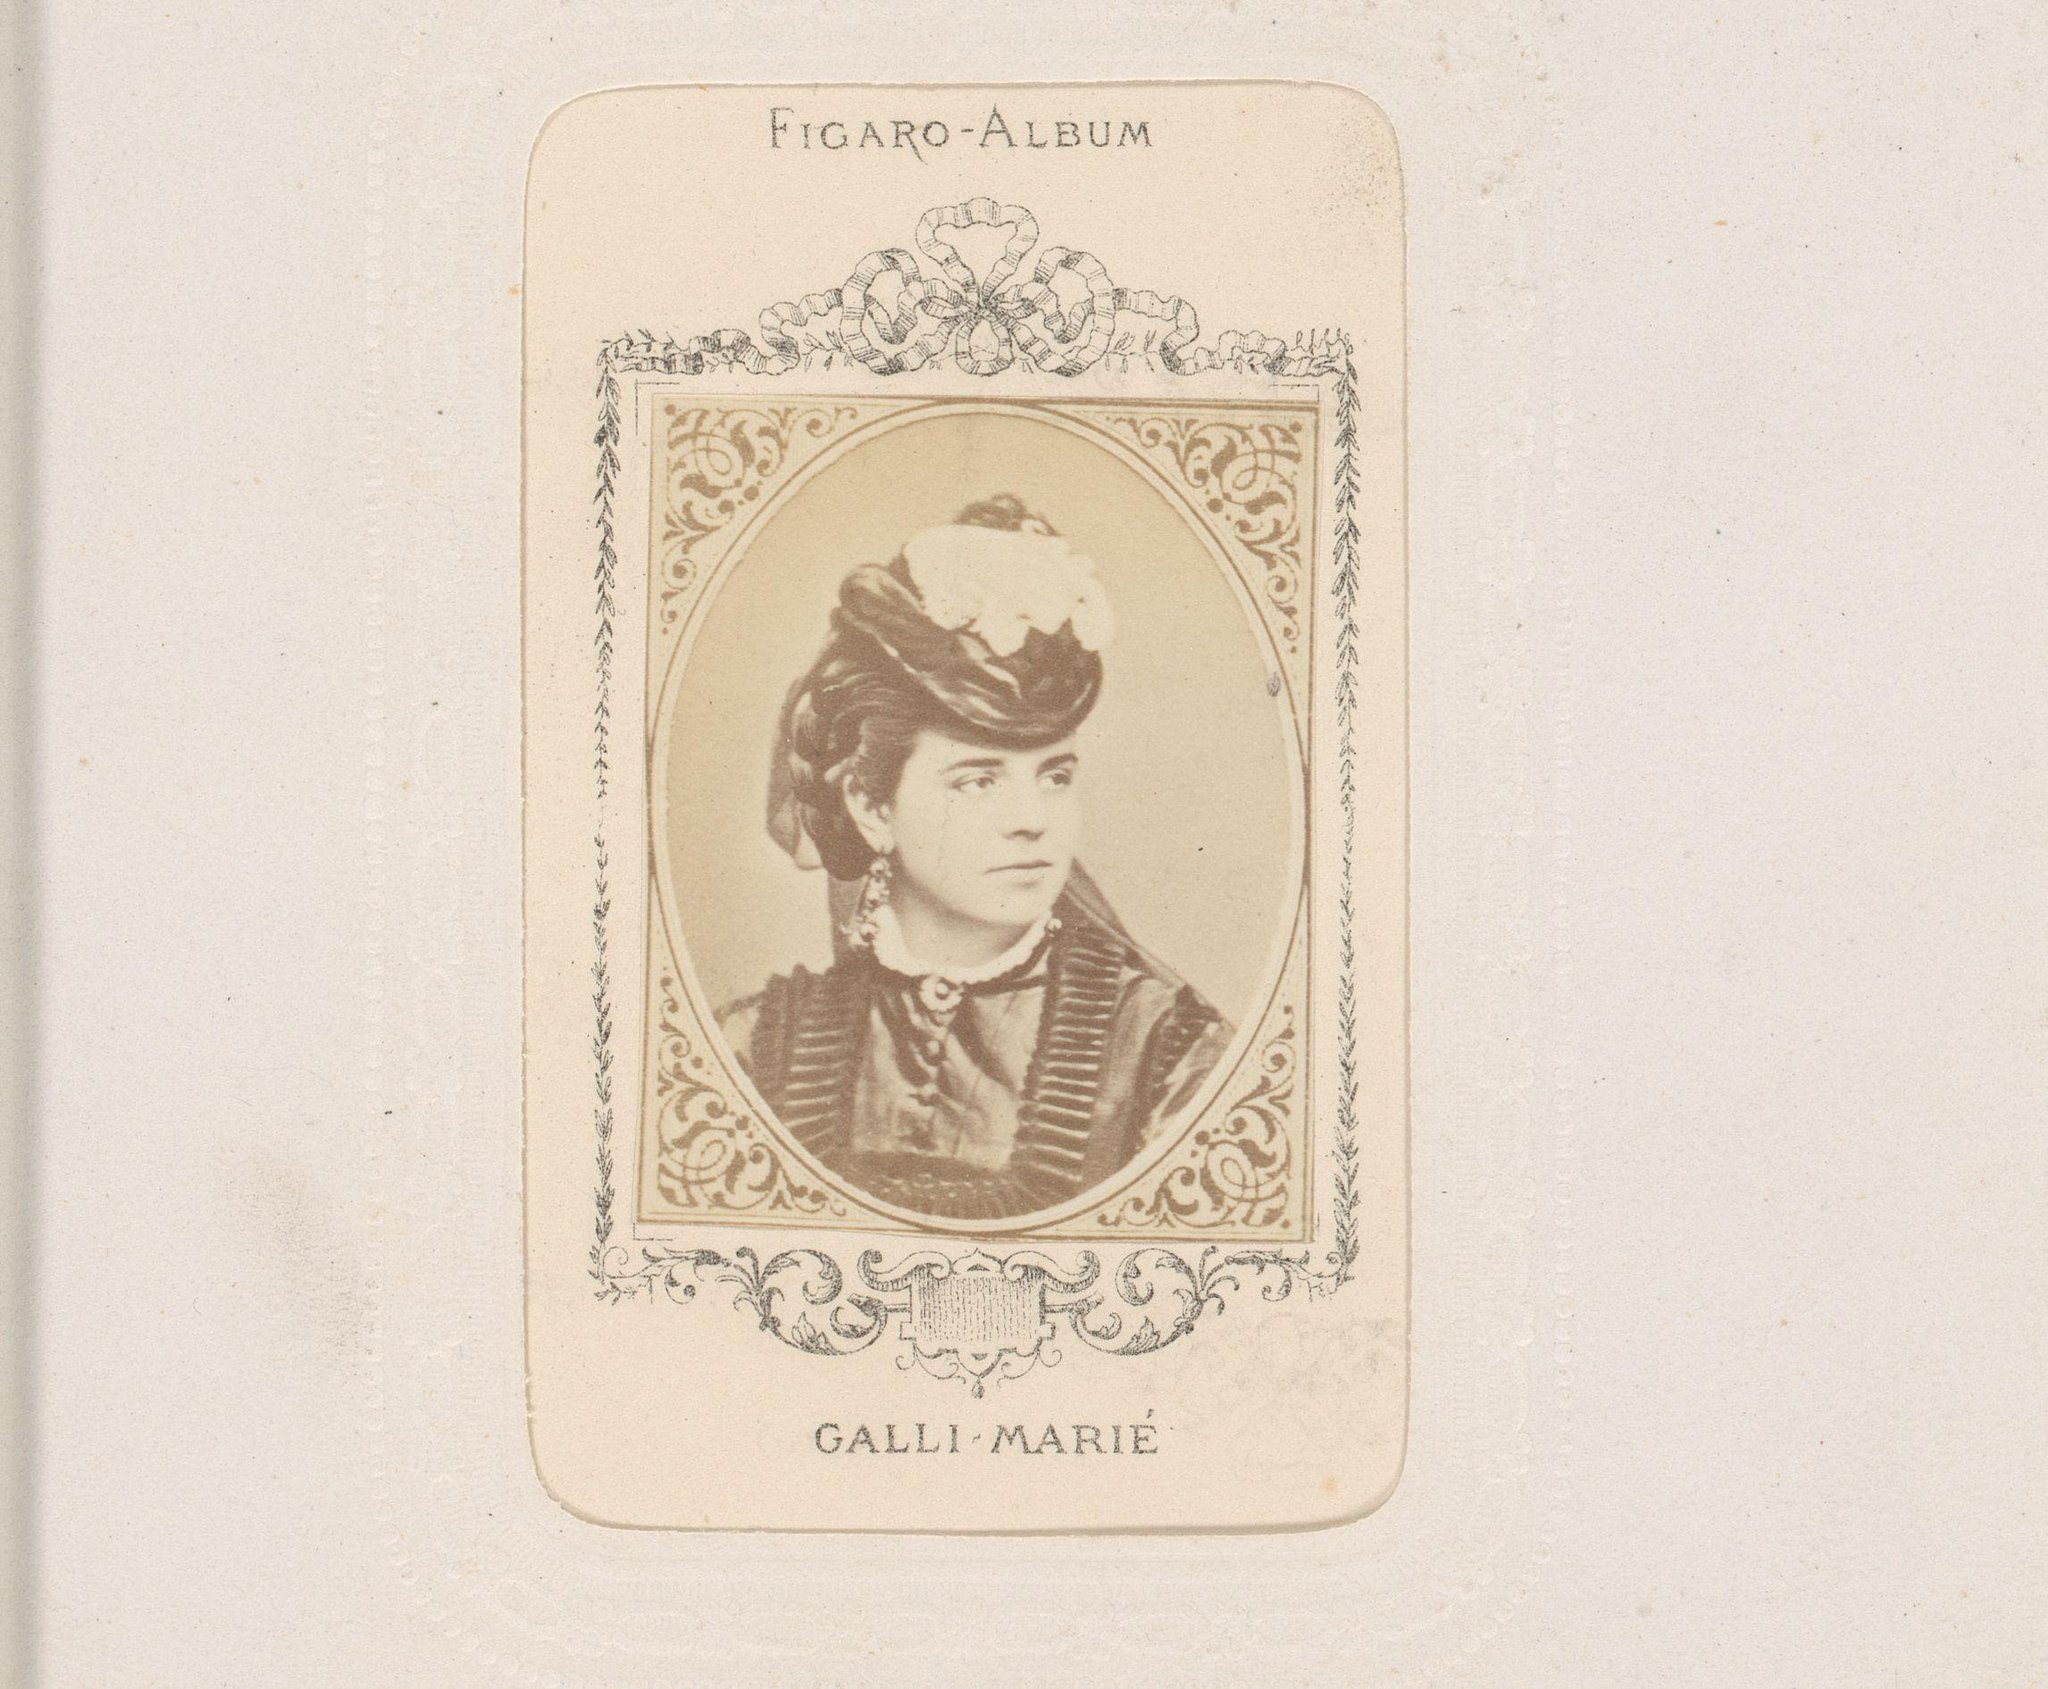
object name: carte de visite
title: Fotoreproductie van een portret van Célestine Galli-Marié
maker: Anonymous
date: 1860-1900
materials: cardboard, photographic support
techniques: albumen print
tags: historical persons - bb - woman, opera-singer (female)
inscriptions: inscription: ‘Figaro-Album/ Galli-Marié’